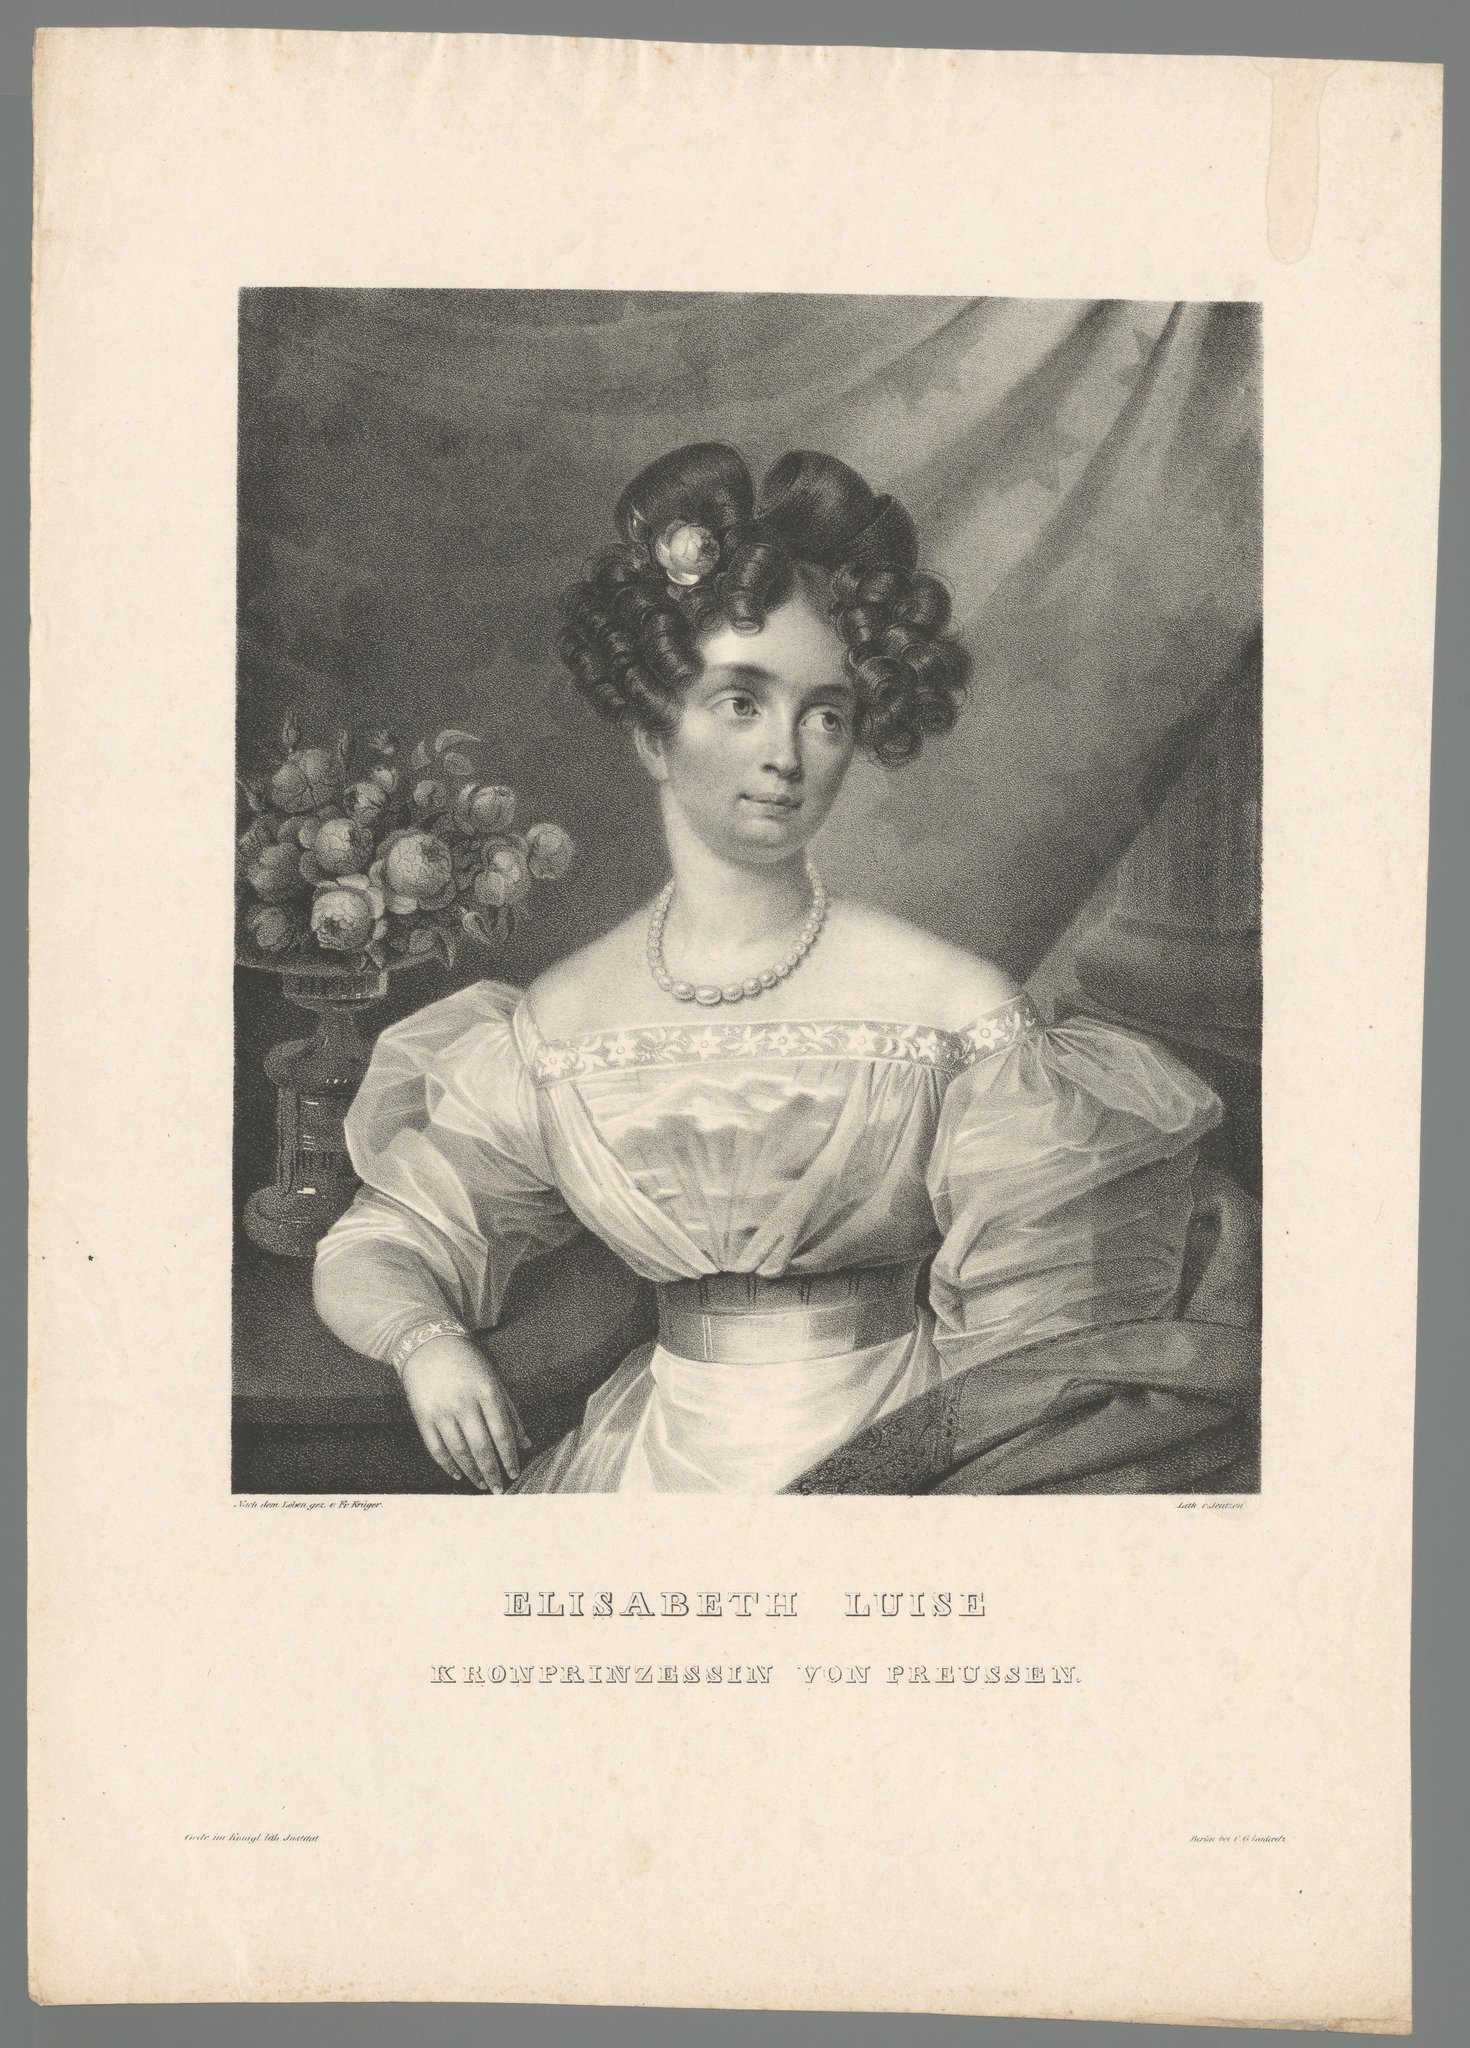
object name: print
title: Elisabeth Luise, Kronprinzessin von Preussen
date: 1823-1837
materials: paper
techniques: lithograph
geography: berlin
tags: flowers, adult woman, historical persons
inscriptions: collector's mark: Lugt 2228, check stamp: Lugt 4519